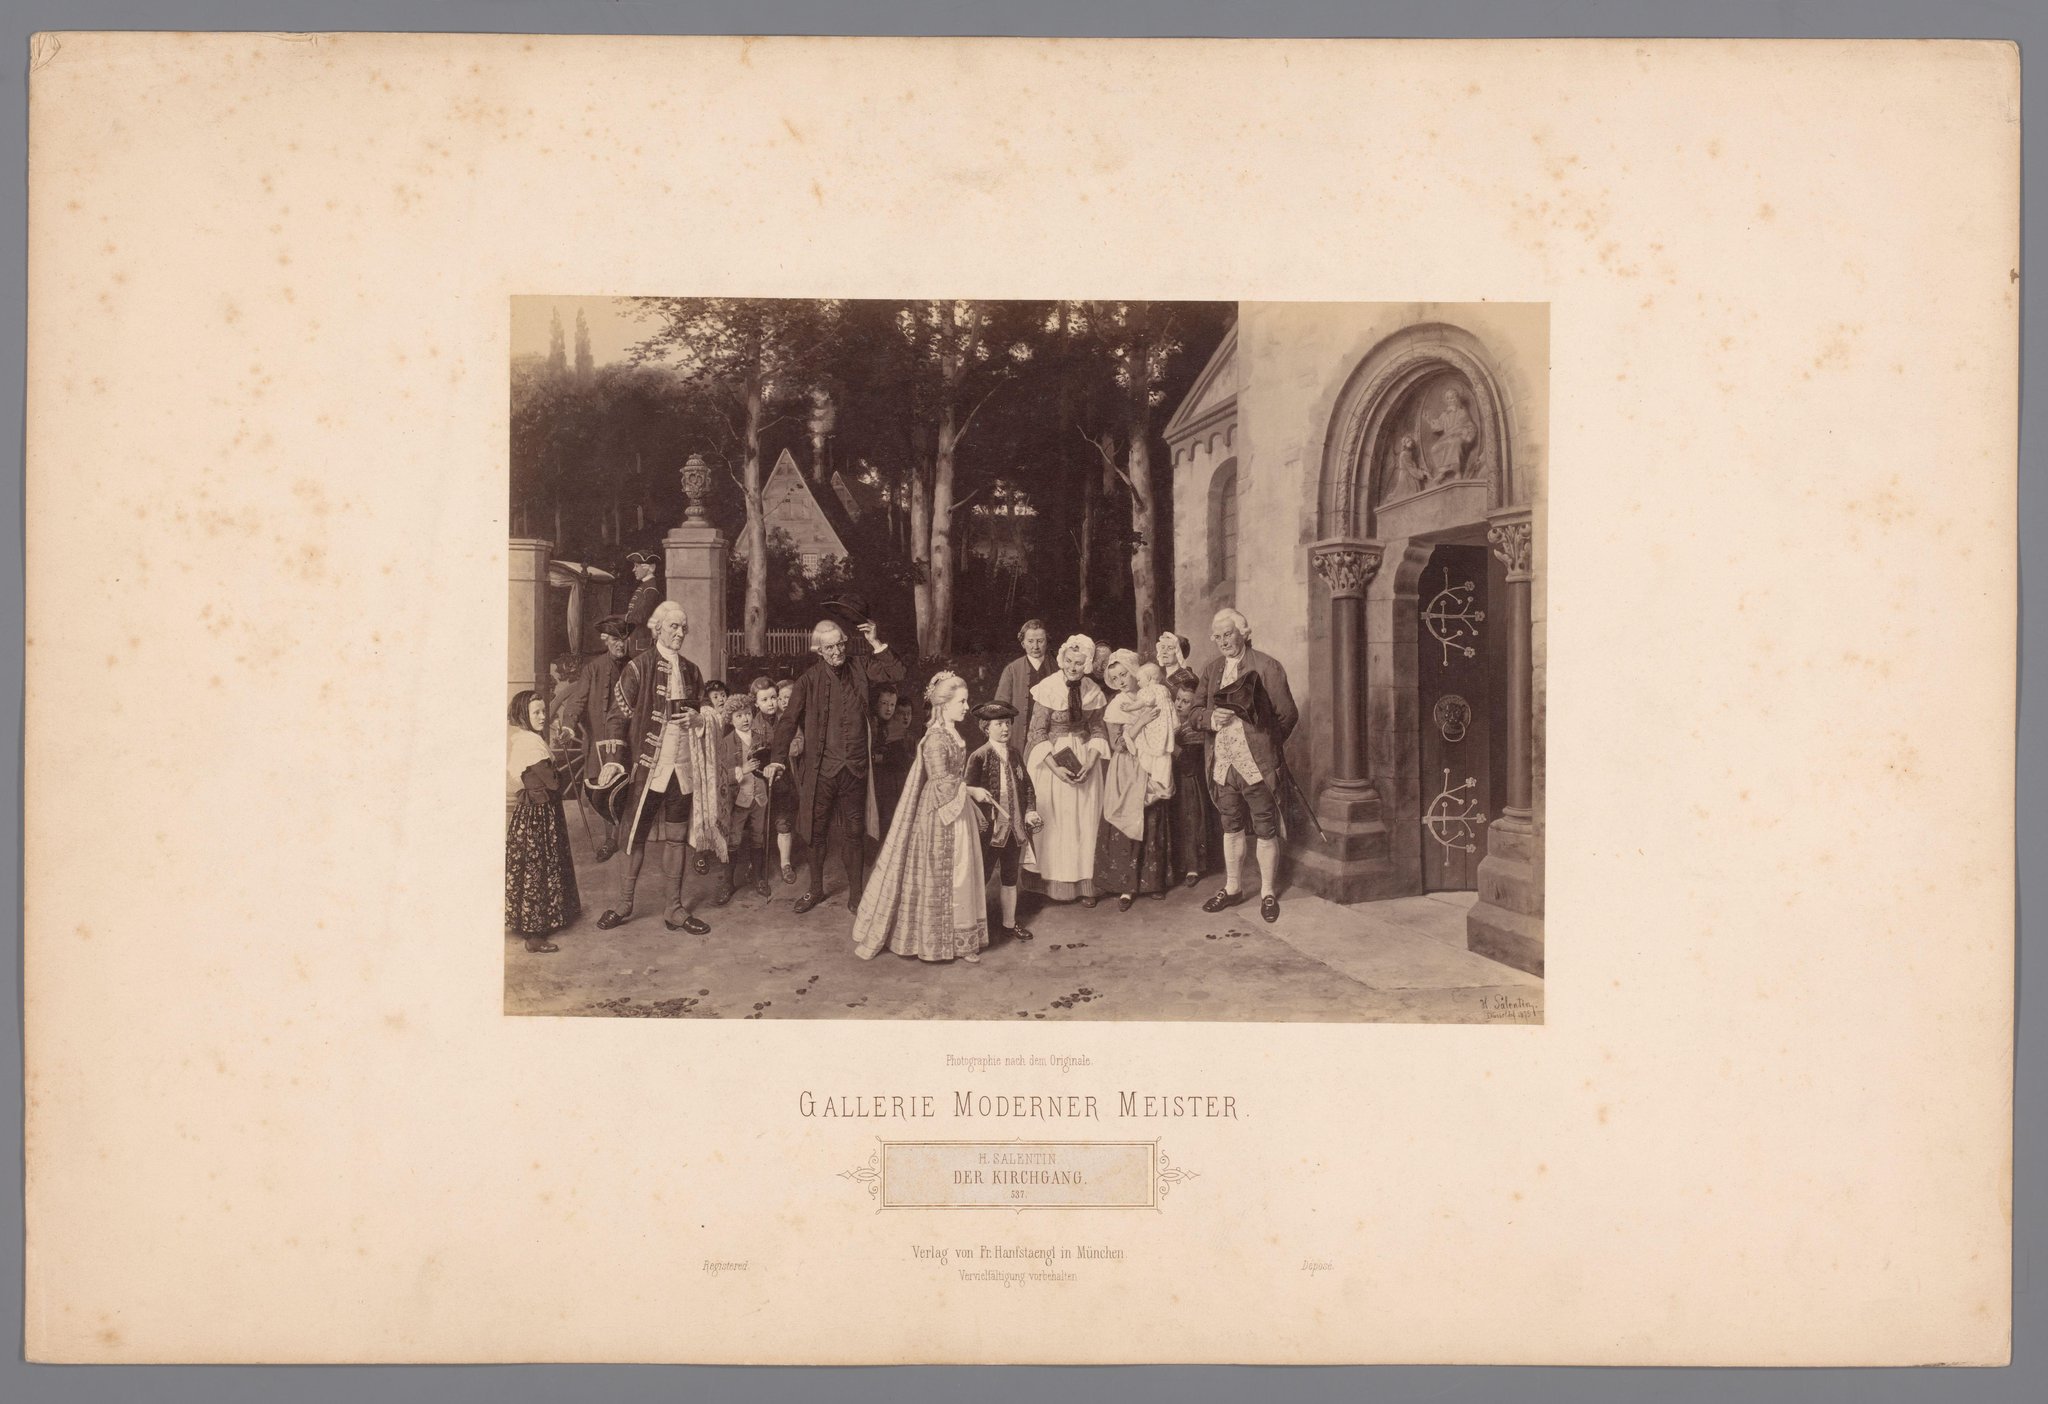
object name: photograph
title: Reproductie van schilderij "Der Kirchgang" van H. Salentin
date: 1875-1900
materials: cardboard, paper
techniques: albumen print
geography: munich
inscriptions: caption: ‘Photographie nach dem Originale.//GALLERIE MODERNER MEISTER//H. SALENTIN//DER KIRCHGANG//537.//Verlag von Fr. Hanfstaengl in München//Verfielfältigung vorbehalten.//Registered//Déposé’